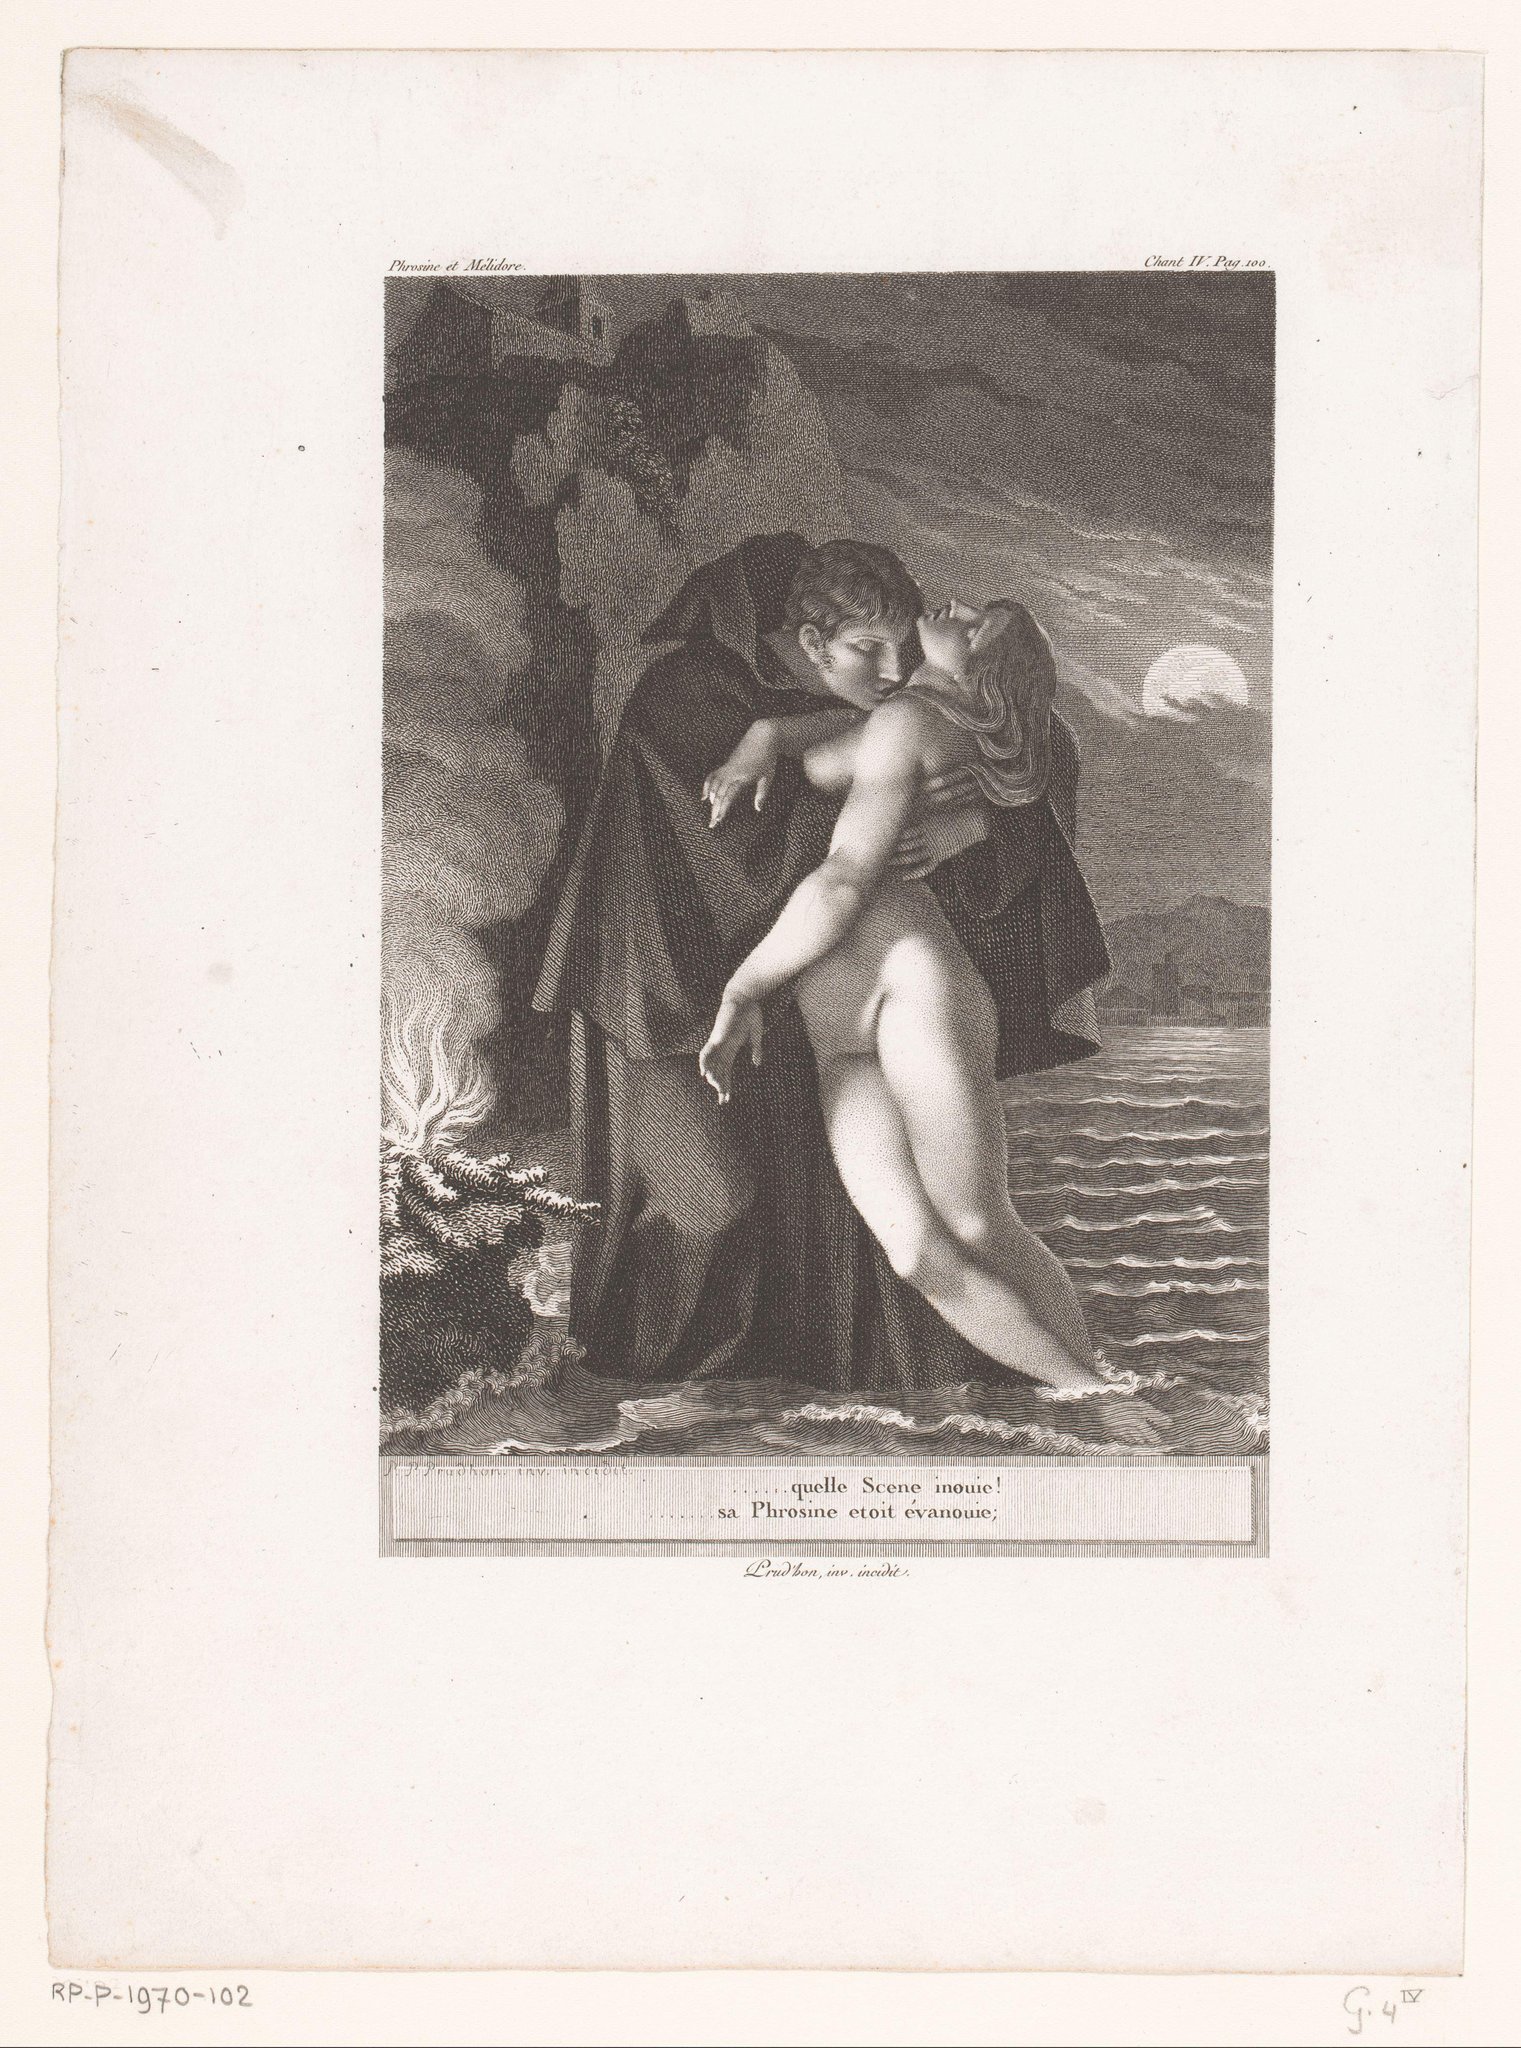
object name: book illustration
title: Phrosine et Mélidore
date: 1797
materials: paper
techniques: engraving, etching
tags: saving a person from drowning, couple of lovers, sea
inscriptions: collector's mark: Lugt 2760, collector's mark: Lugt 2228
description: Scène uit het gedicht van Pierre-Joseph Bernard. Mélidore redt zijn geliefde Phrosine uit de zee.